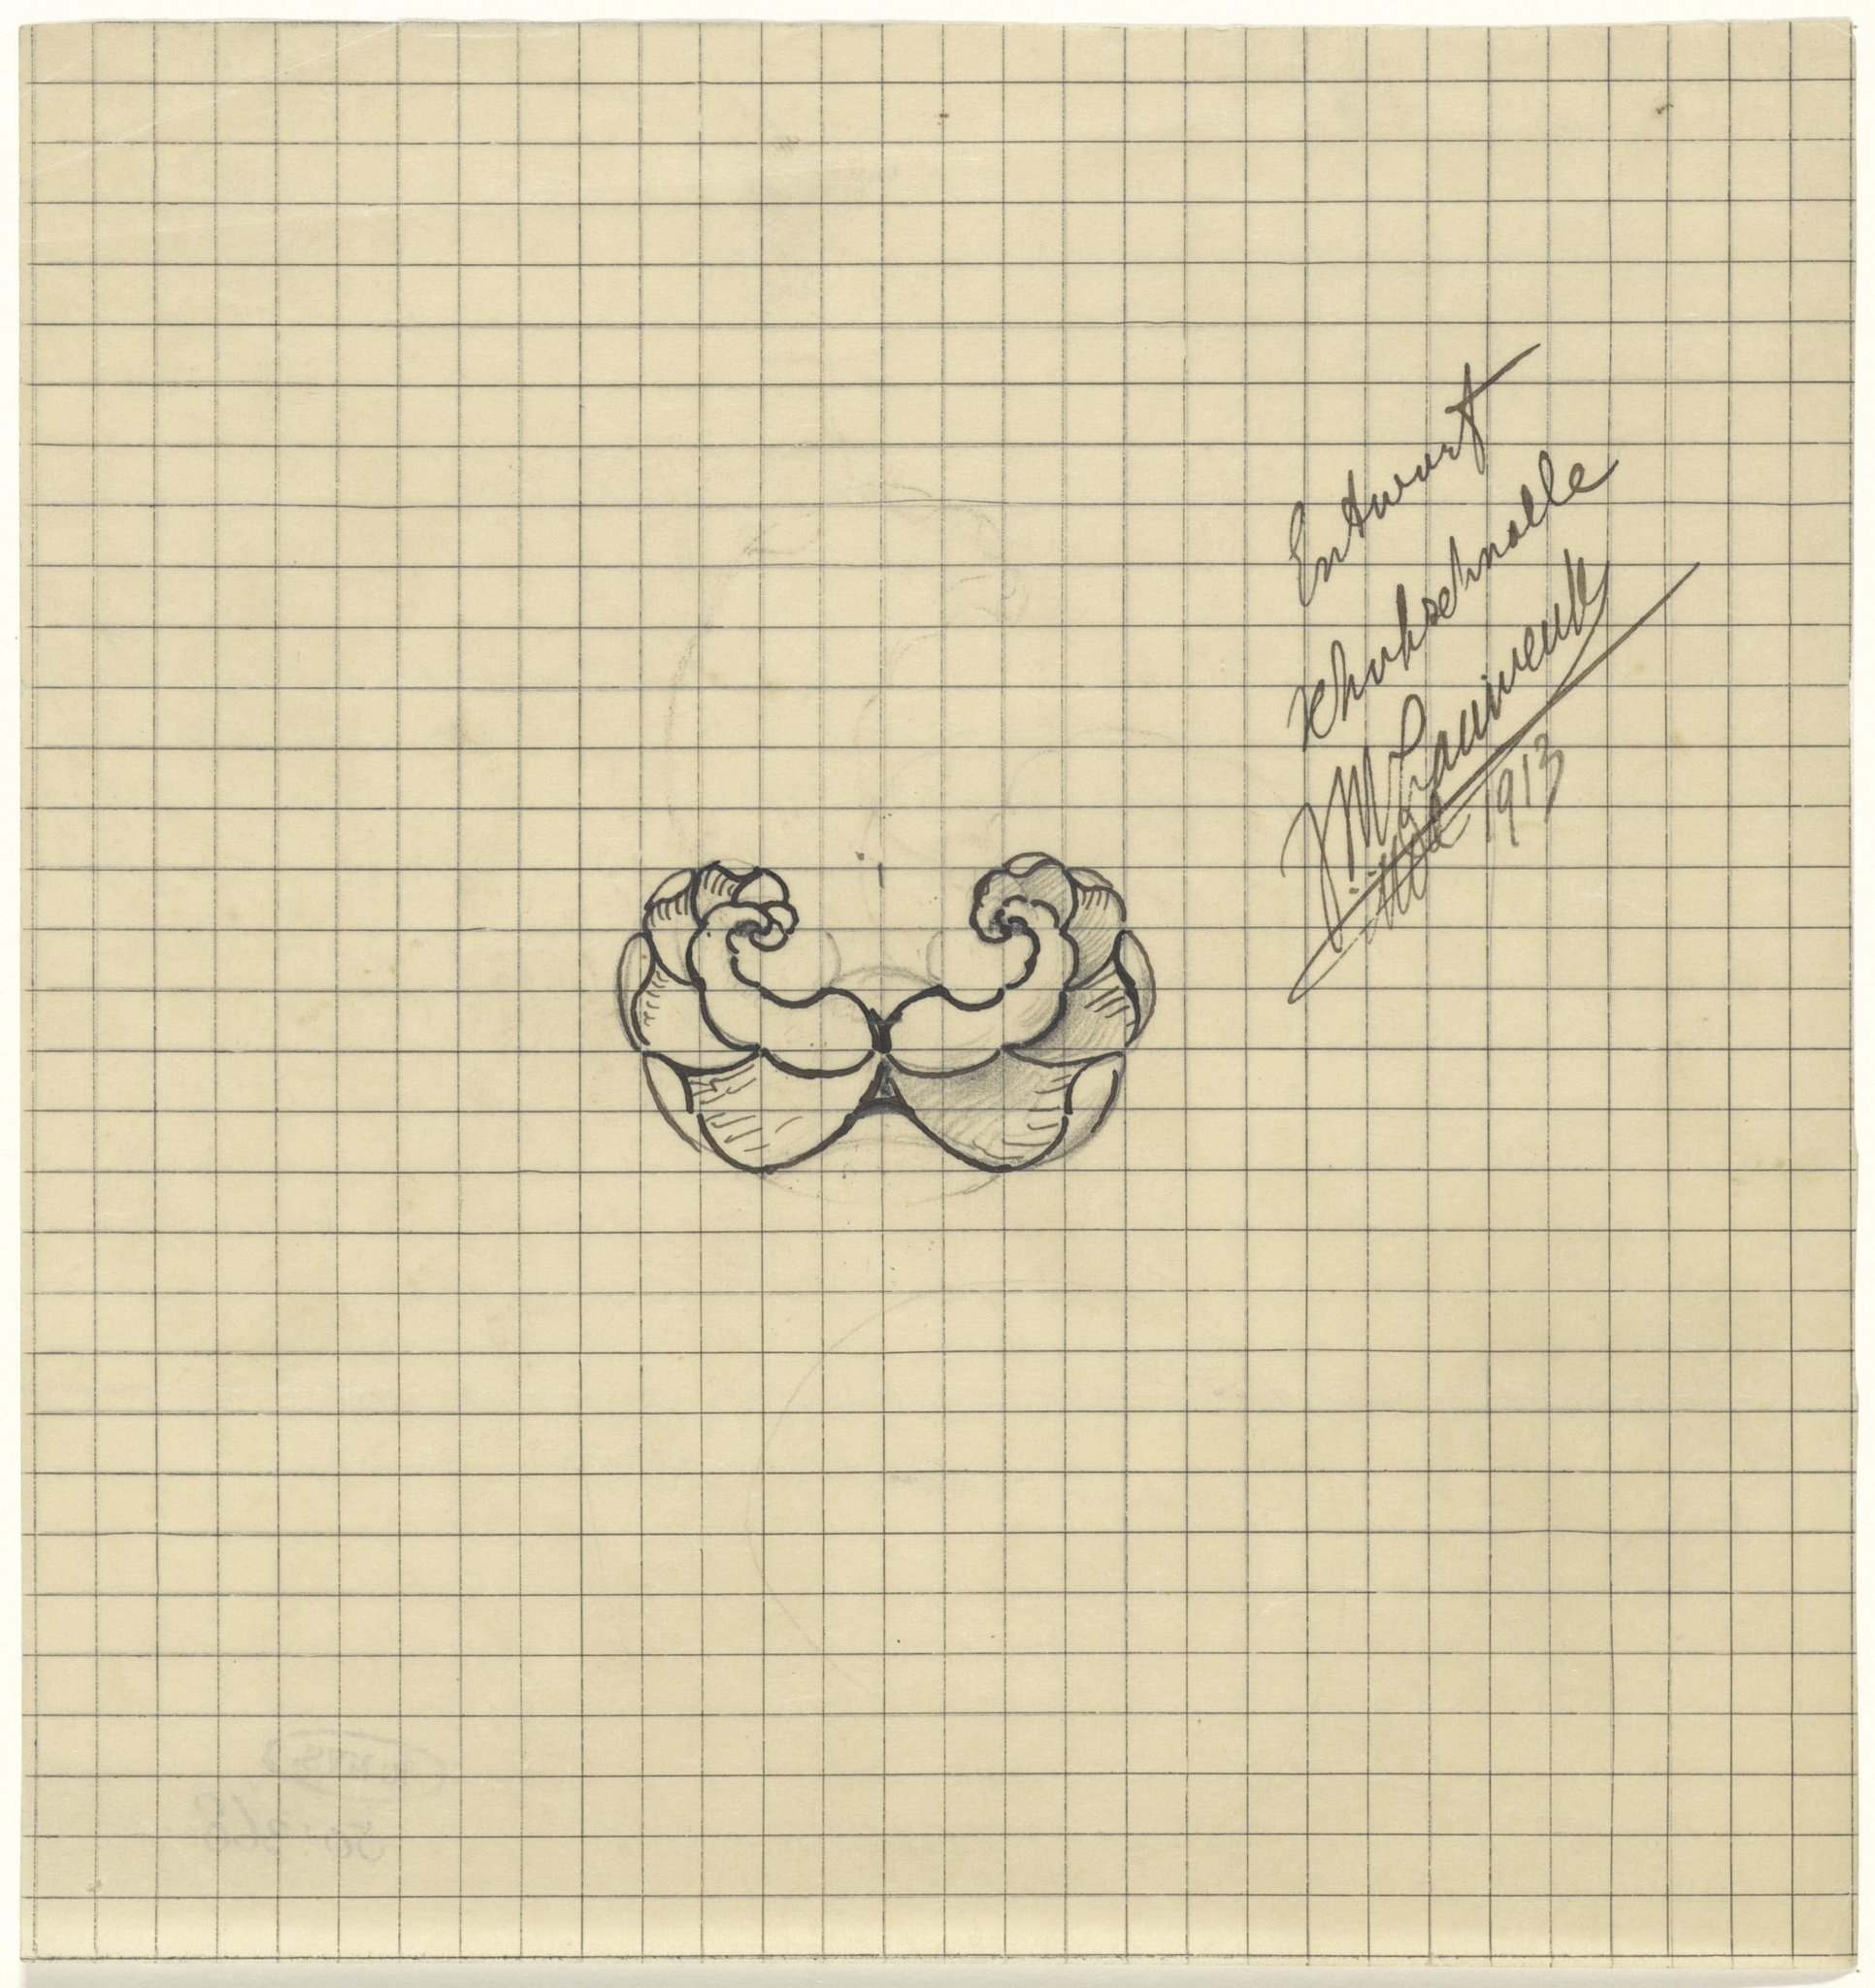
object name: drawing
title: Ontwerp voor een schoengesp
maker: mathieu lauweriks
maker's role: designer, draughtsman, print maker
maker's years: 1864-1932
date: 1913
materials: ink, pencil, paper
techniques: pen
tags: buckle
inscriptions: date: ‘1913’